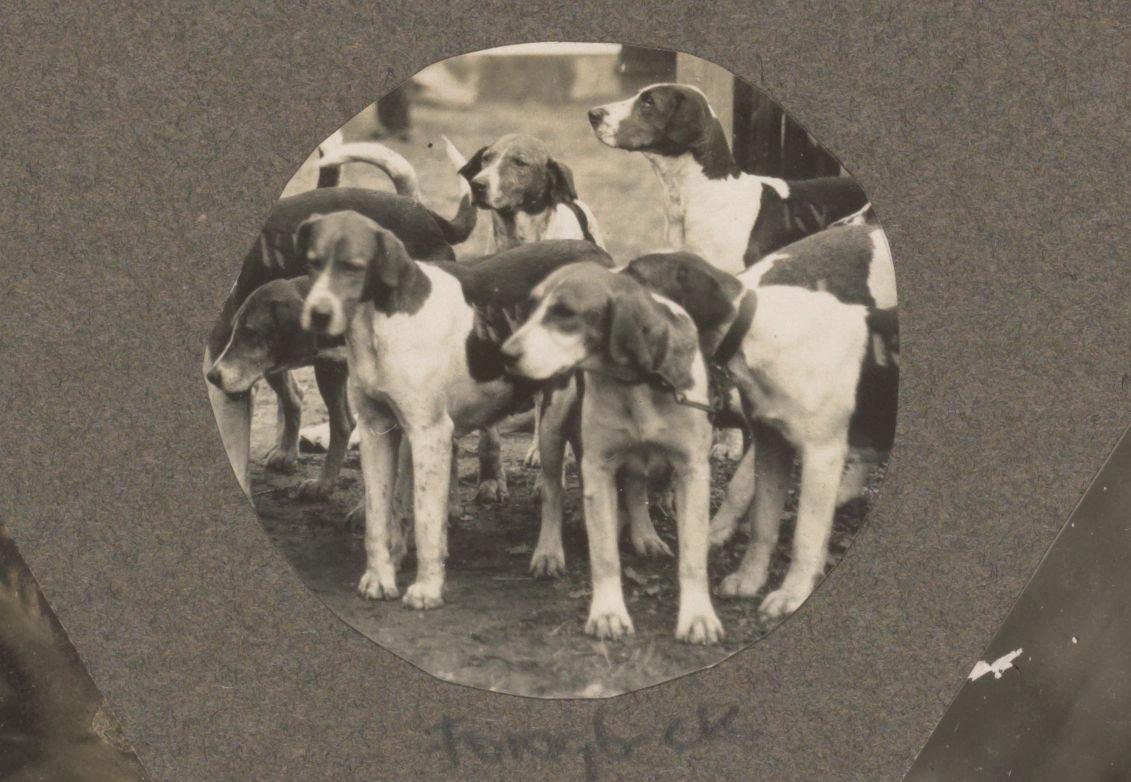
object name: album leaf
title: Ruitertafereel op Koninklijke Houtvesterij Het Loo: meute honden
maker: Anonymous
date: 1900-1925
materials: photographic support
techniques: gelatin silver print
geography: het loo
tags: hunting, chase, hunting dogs, hunting-ground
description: Onderdeel van Fotoalbum van de heer Brams, opperhoutvester van koningin Wilhelmina op Koninklijke Houtvesterij Het Loo.